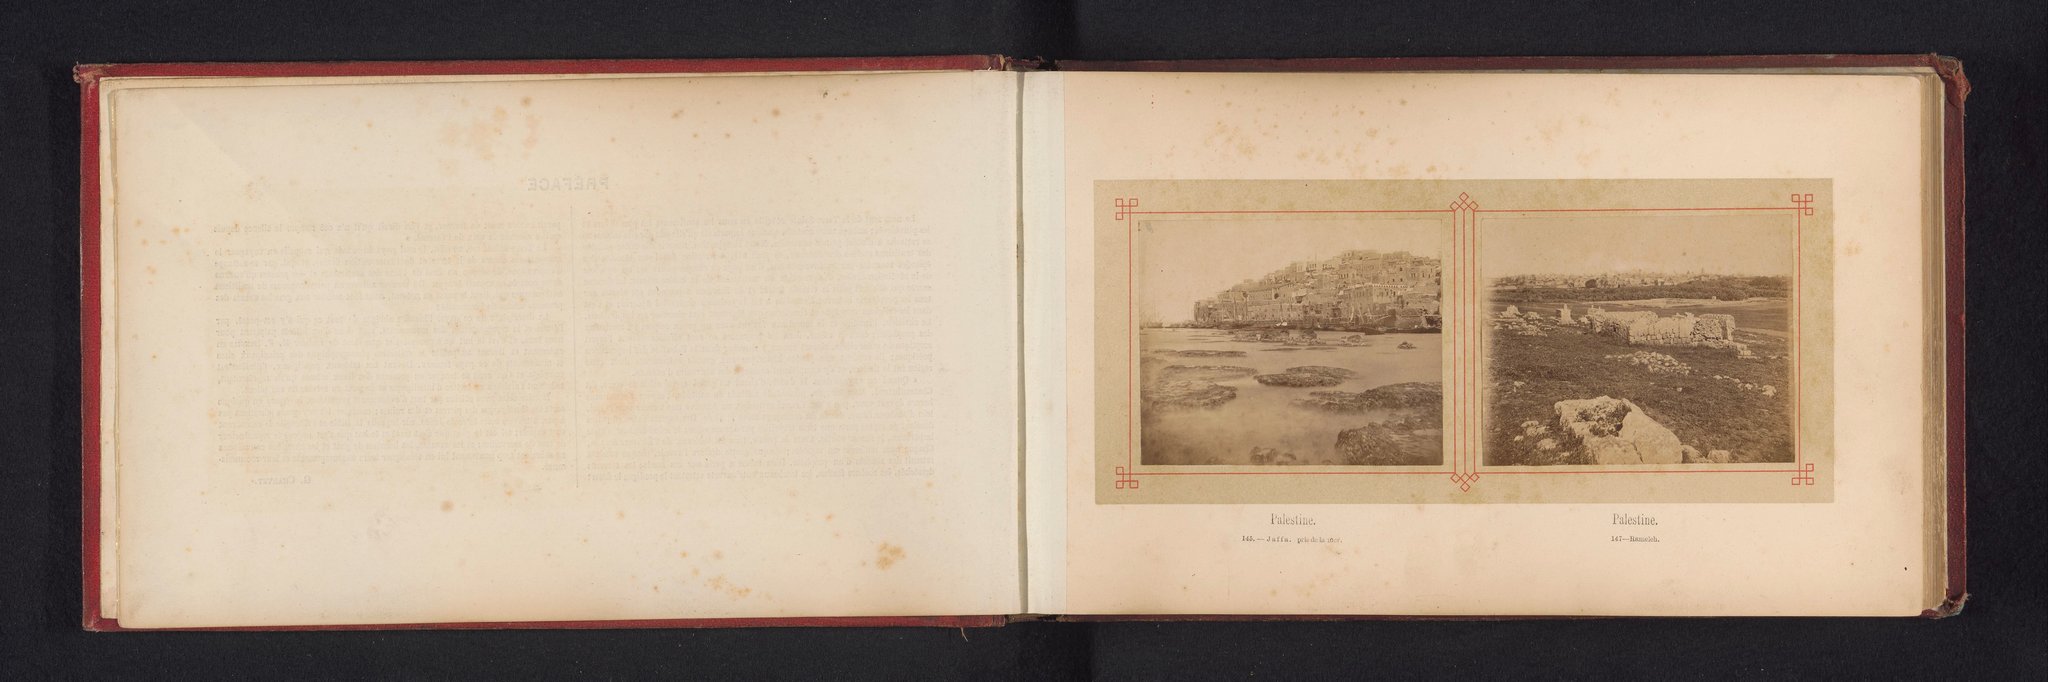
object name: page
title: Gezicht op Jaffa vanaf de Middellandse Zee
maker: félix bonfils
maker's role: fotograaf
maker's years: 1831-1885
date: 1873-1878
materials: photographic support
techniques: albumen print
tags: city-view in general; 'veduta', sea